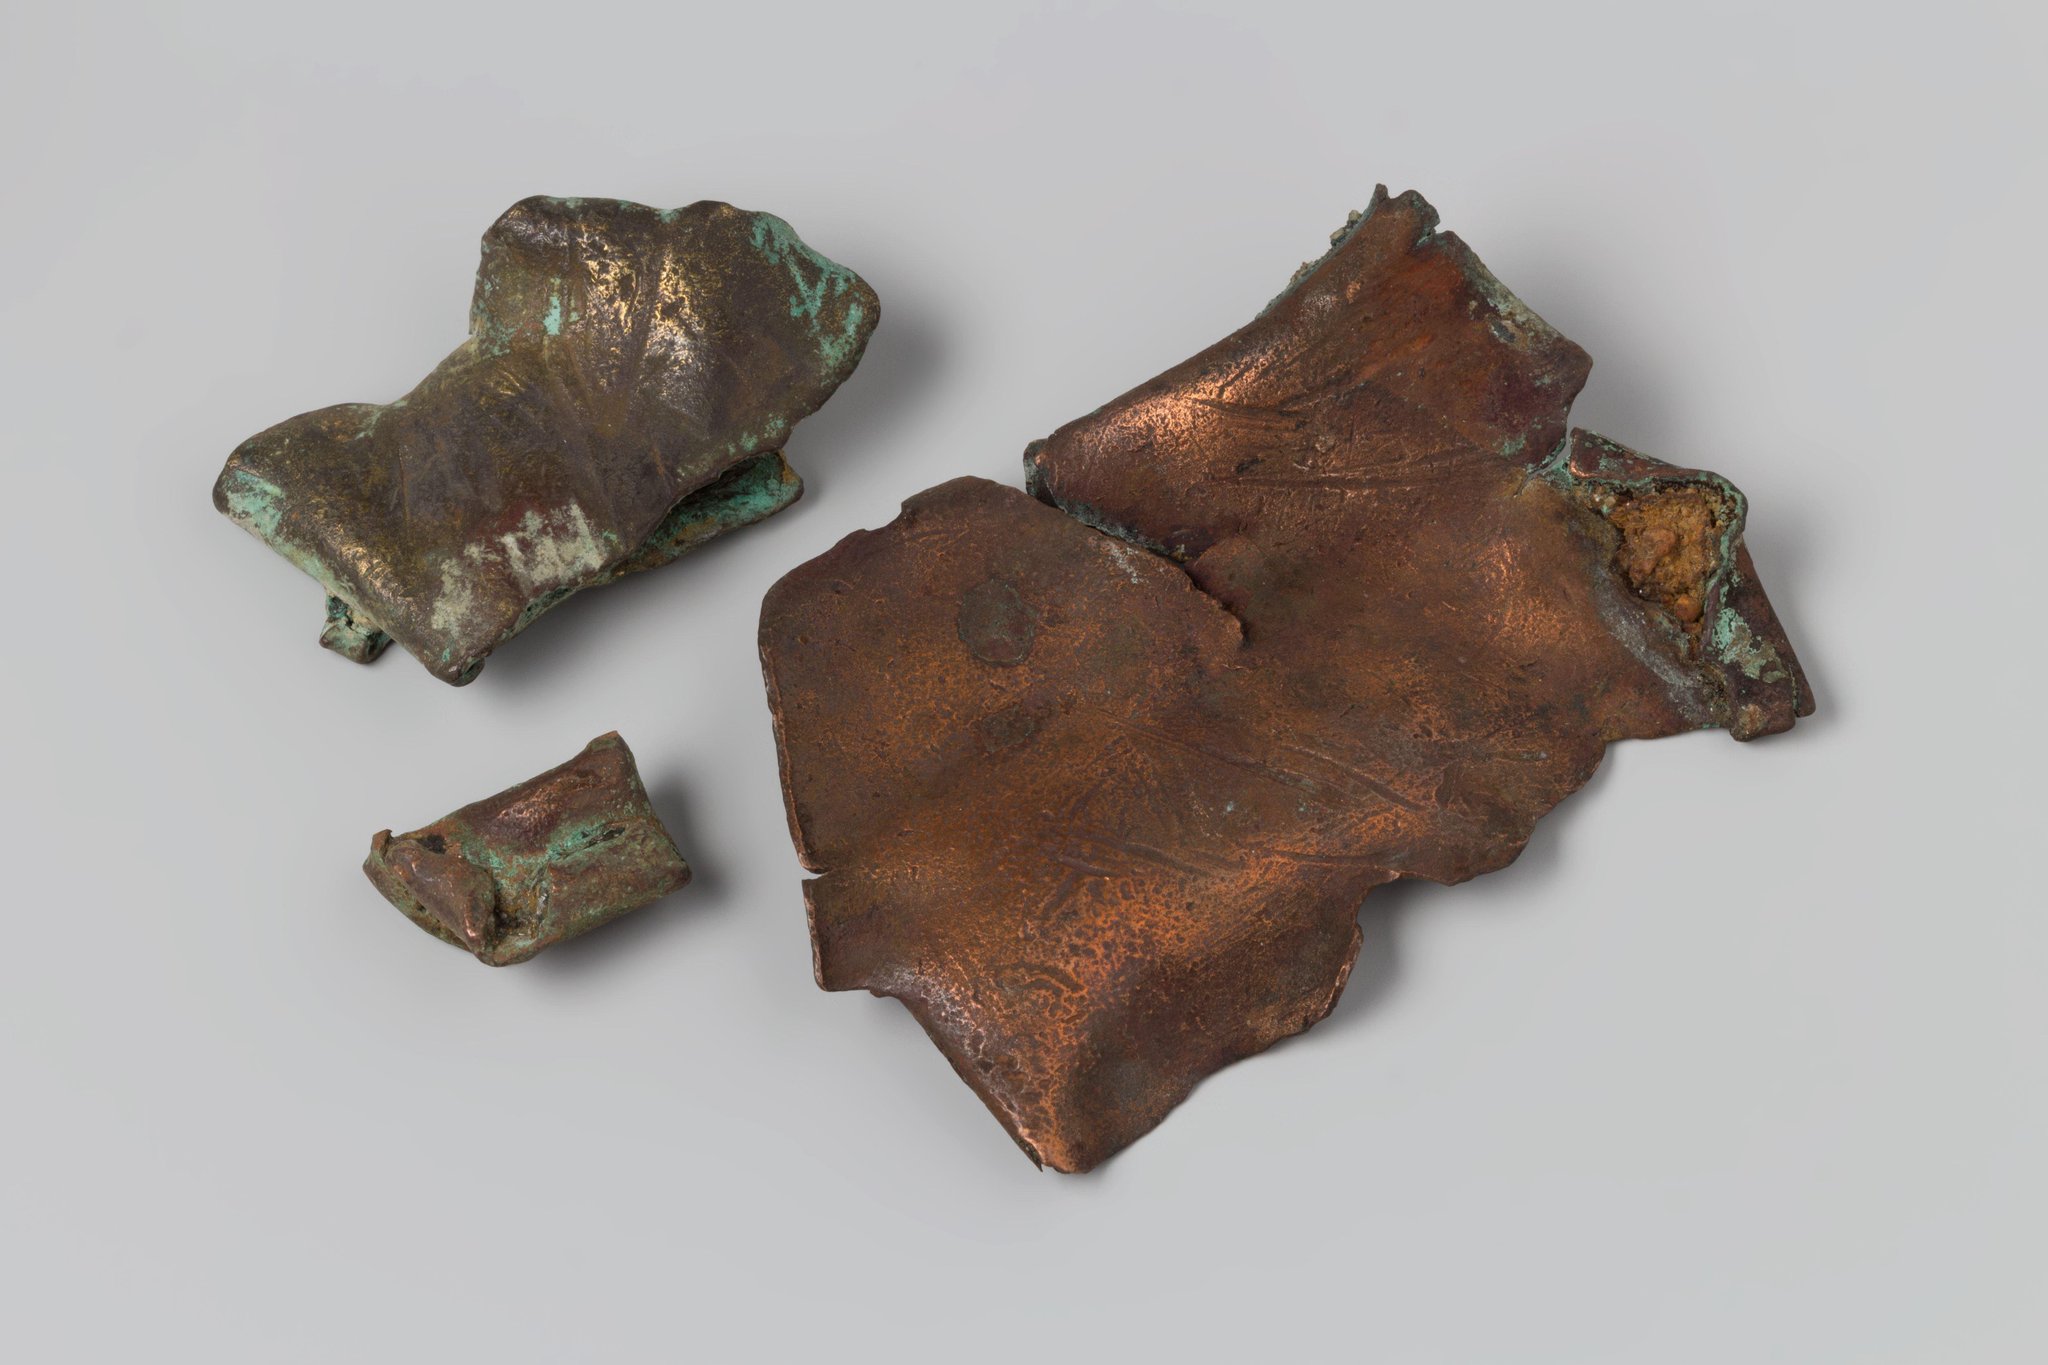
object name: scheepswrakvondst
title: Fragmenten van koper uit het wrak van de Oost-Indiëvaarder Hollandia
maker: Anonymous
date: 1700-1743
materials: copper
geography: netherlands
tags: verenigde oostindische compagnie, hollandia (schip), annet